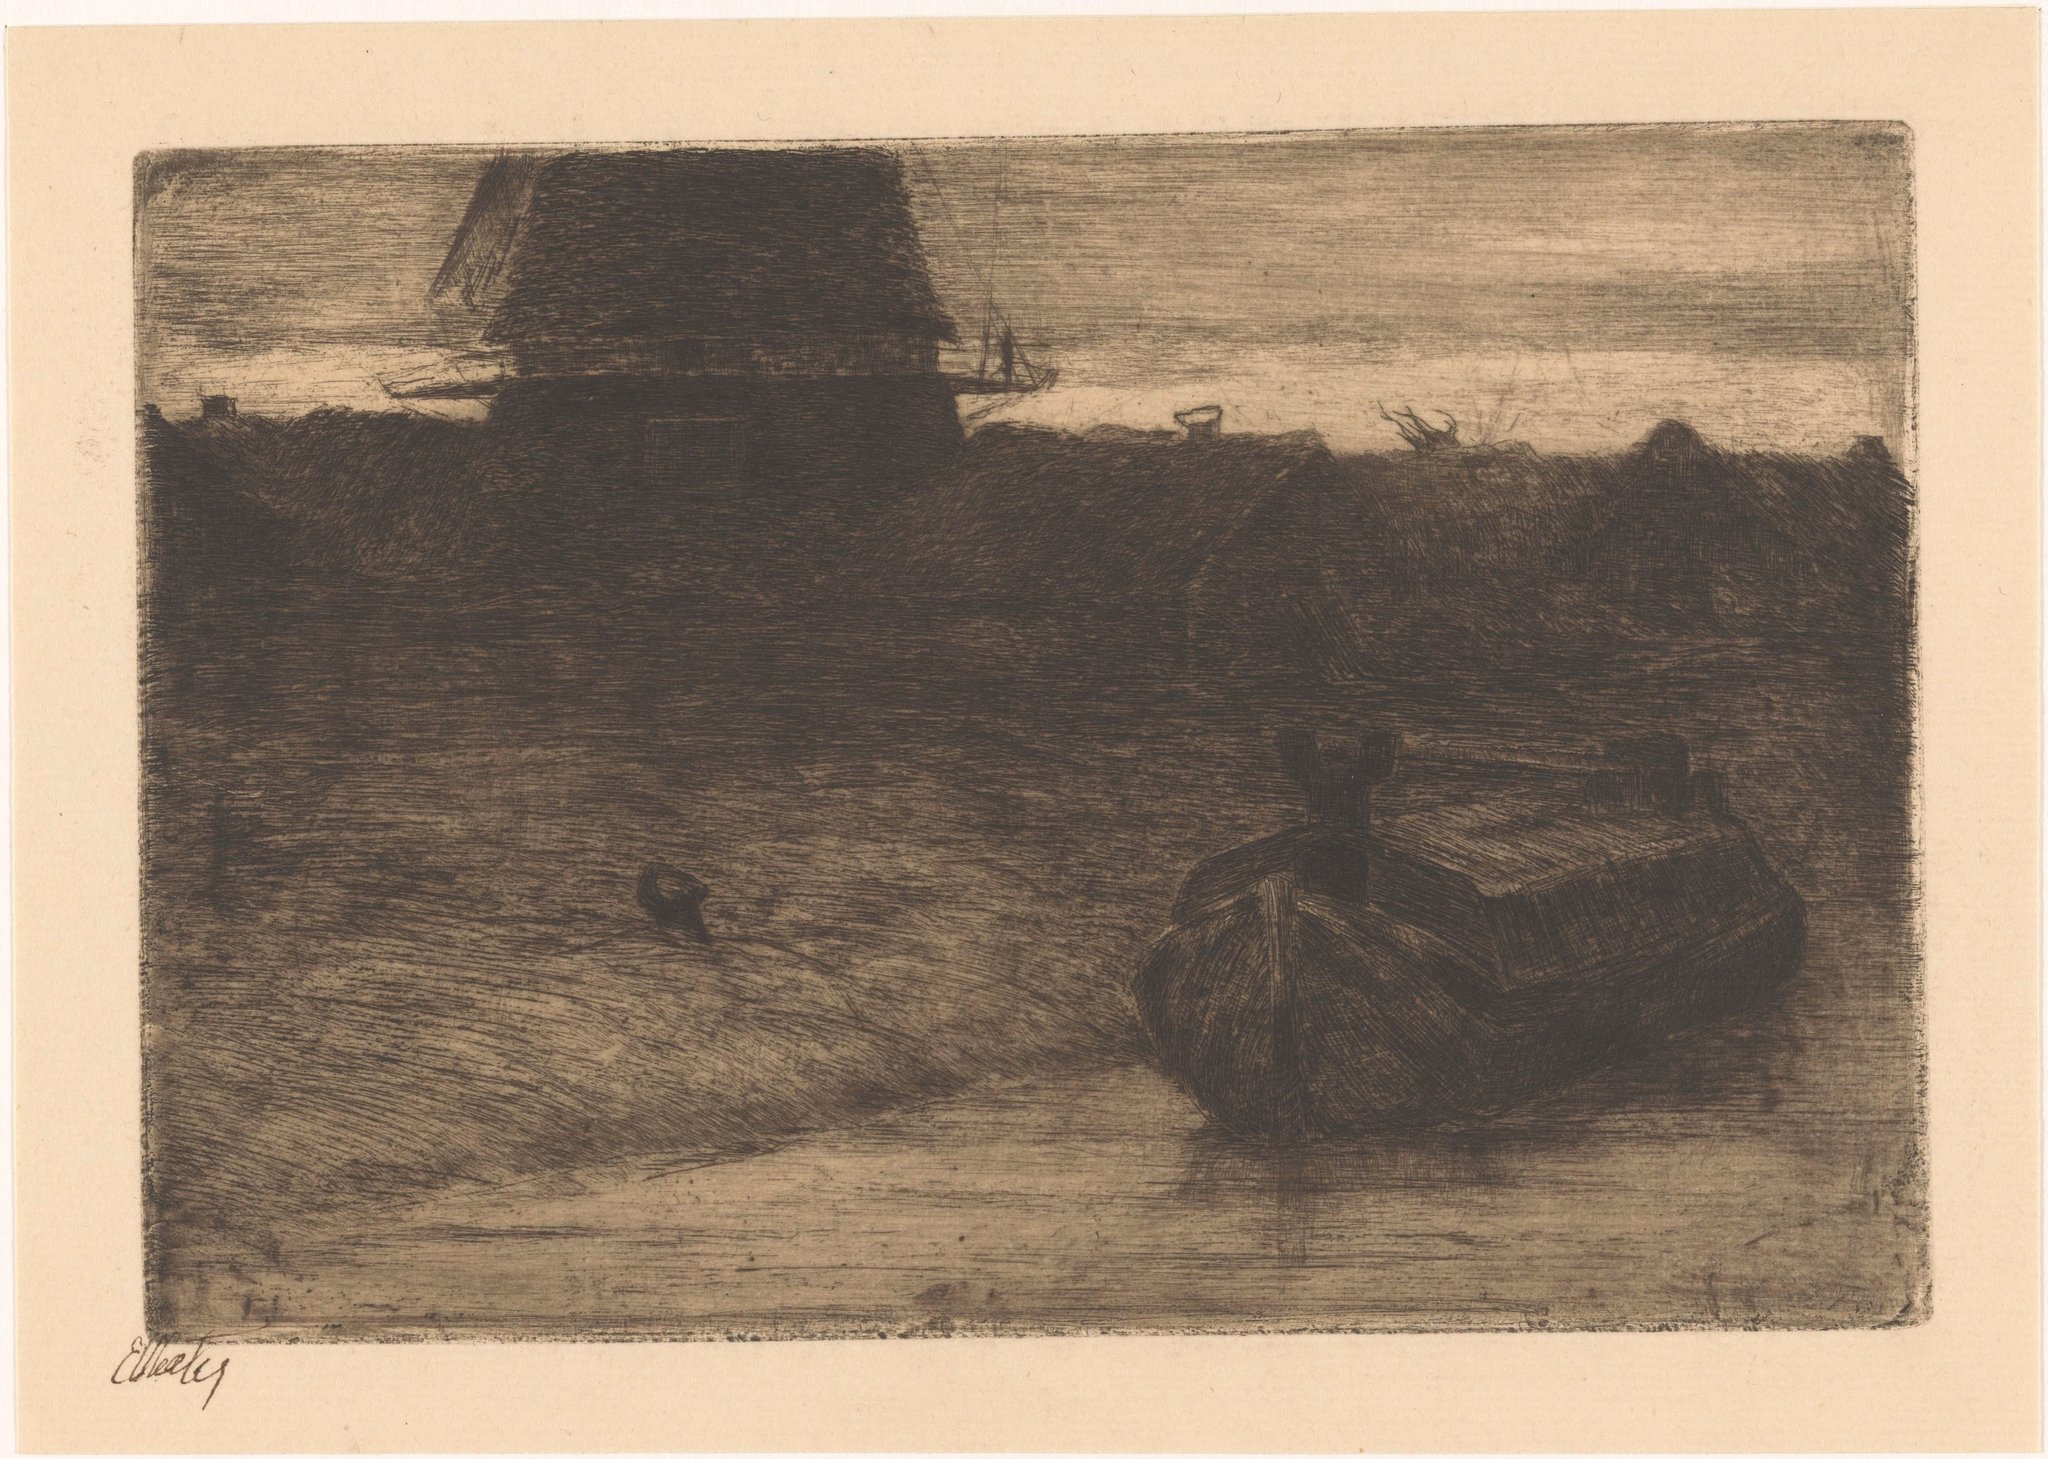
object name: print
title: Schuit op een vaart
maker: etha fles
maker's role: print maker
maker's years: 1857-1948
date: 1867-1910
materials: paper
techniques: drypoint, intaglio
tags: ships (in general), windmill in landscape, small canal, ditch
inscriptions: collector's mark: Lugt 2228